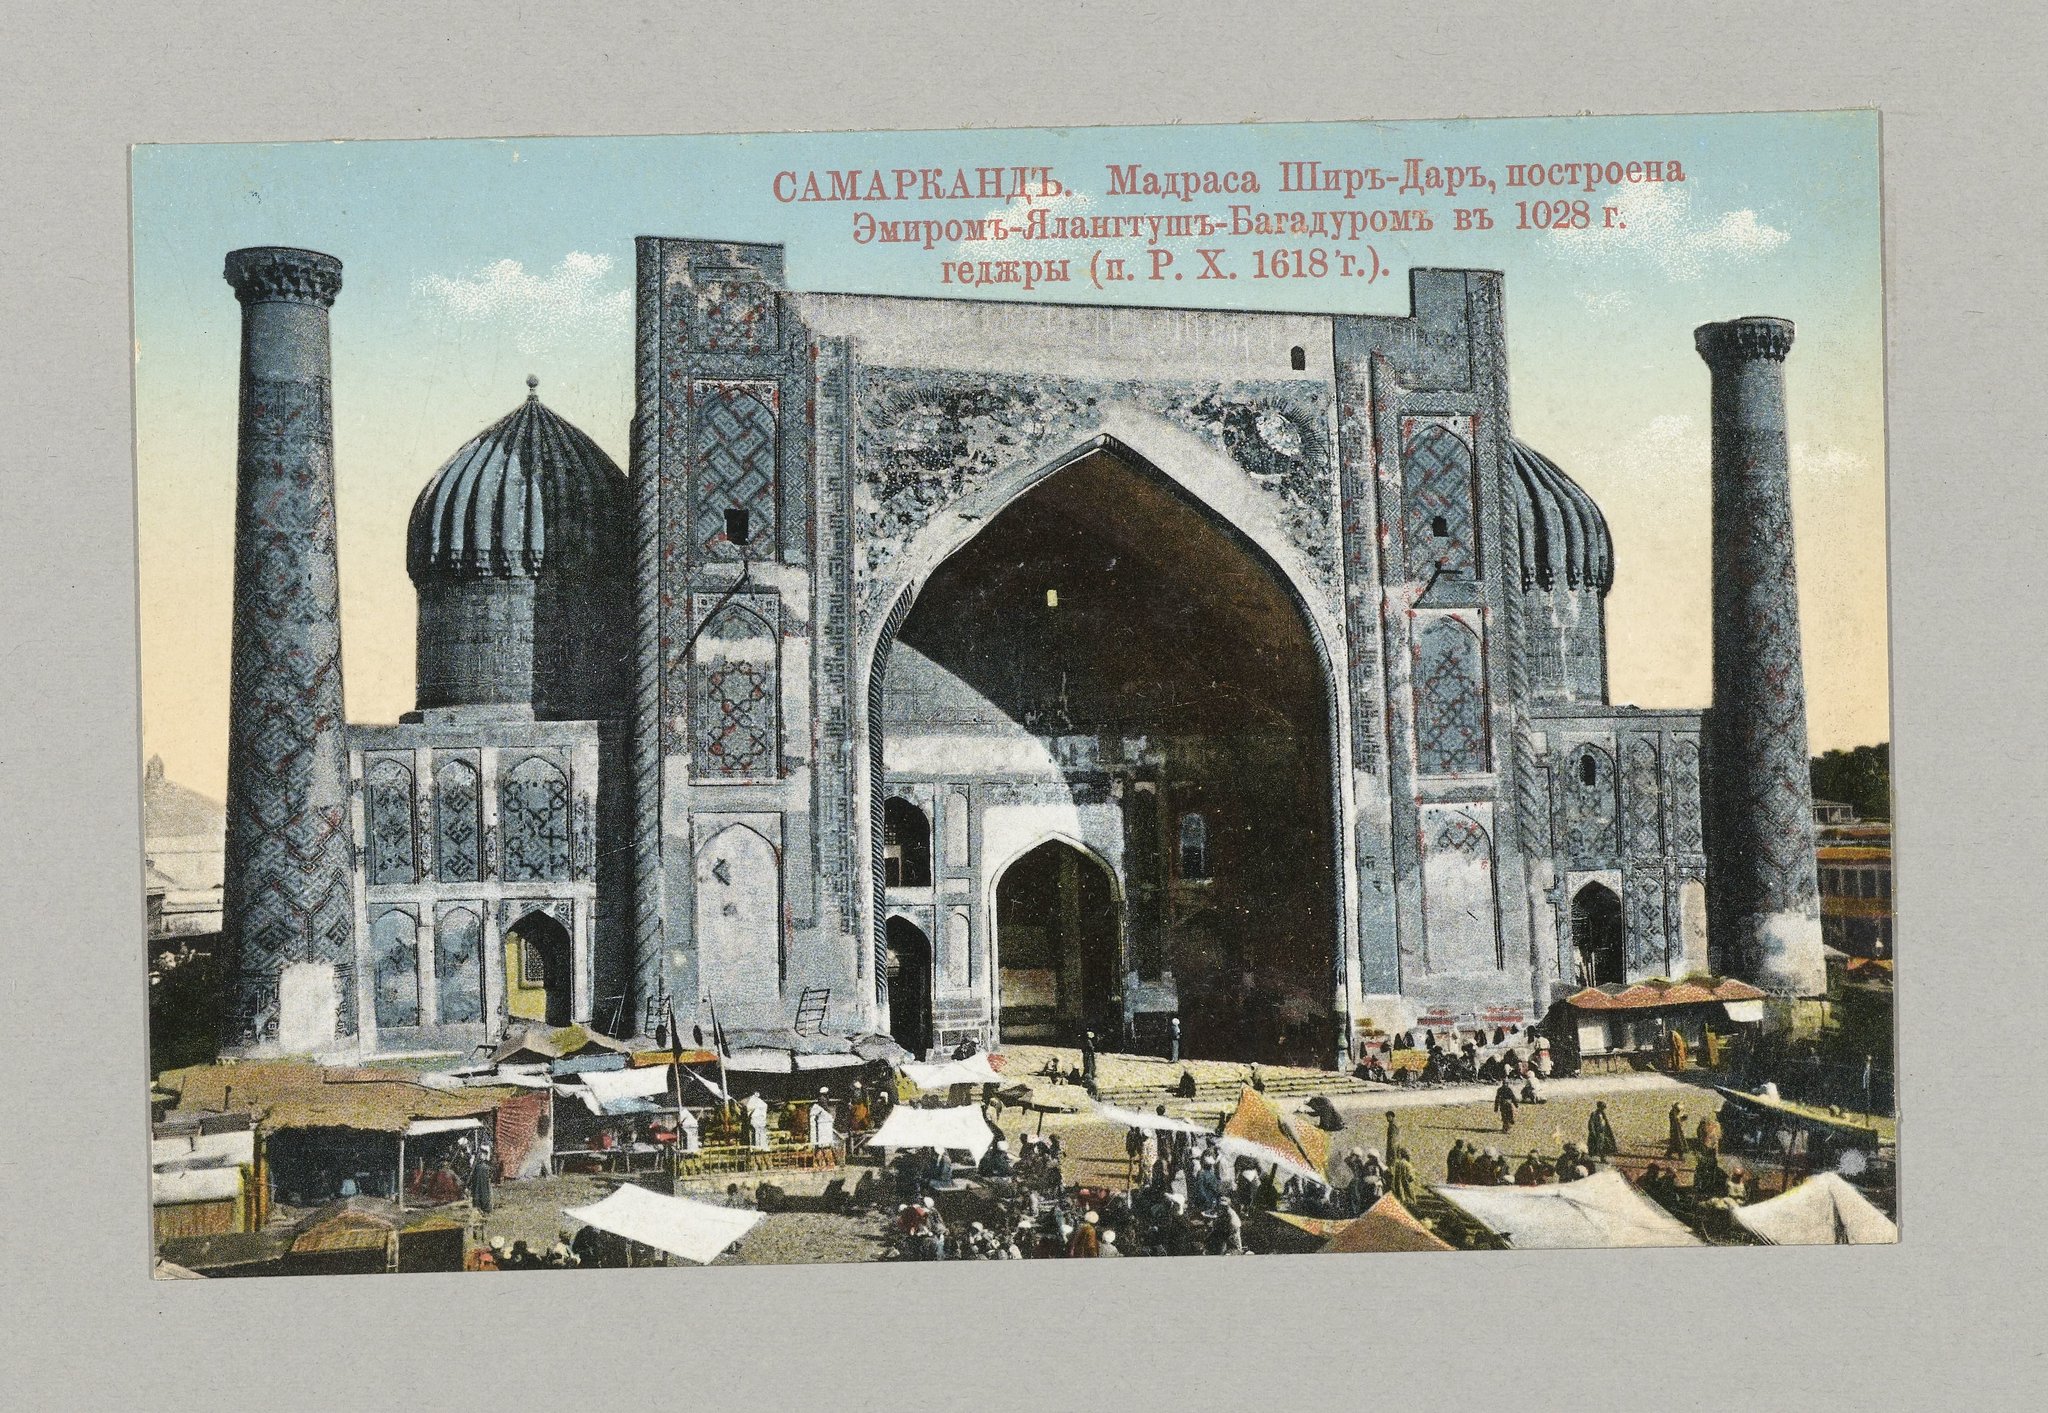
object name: photomechanical print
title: Moskee met scheve minaretten op de marktplaats te Samarkand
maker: Anonymous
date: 1895-1915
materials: cardboard, paper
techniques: photograph, lithograph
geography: samarqand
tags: samarqand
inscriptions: annotation: ‘8 & 6 (verglaasde tegels.) / Nº 9.’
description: Moskee, bovenaan staat uitleg in het Oezbeeks.